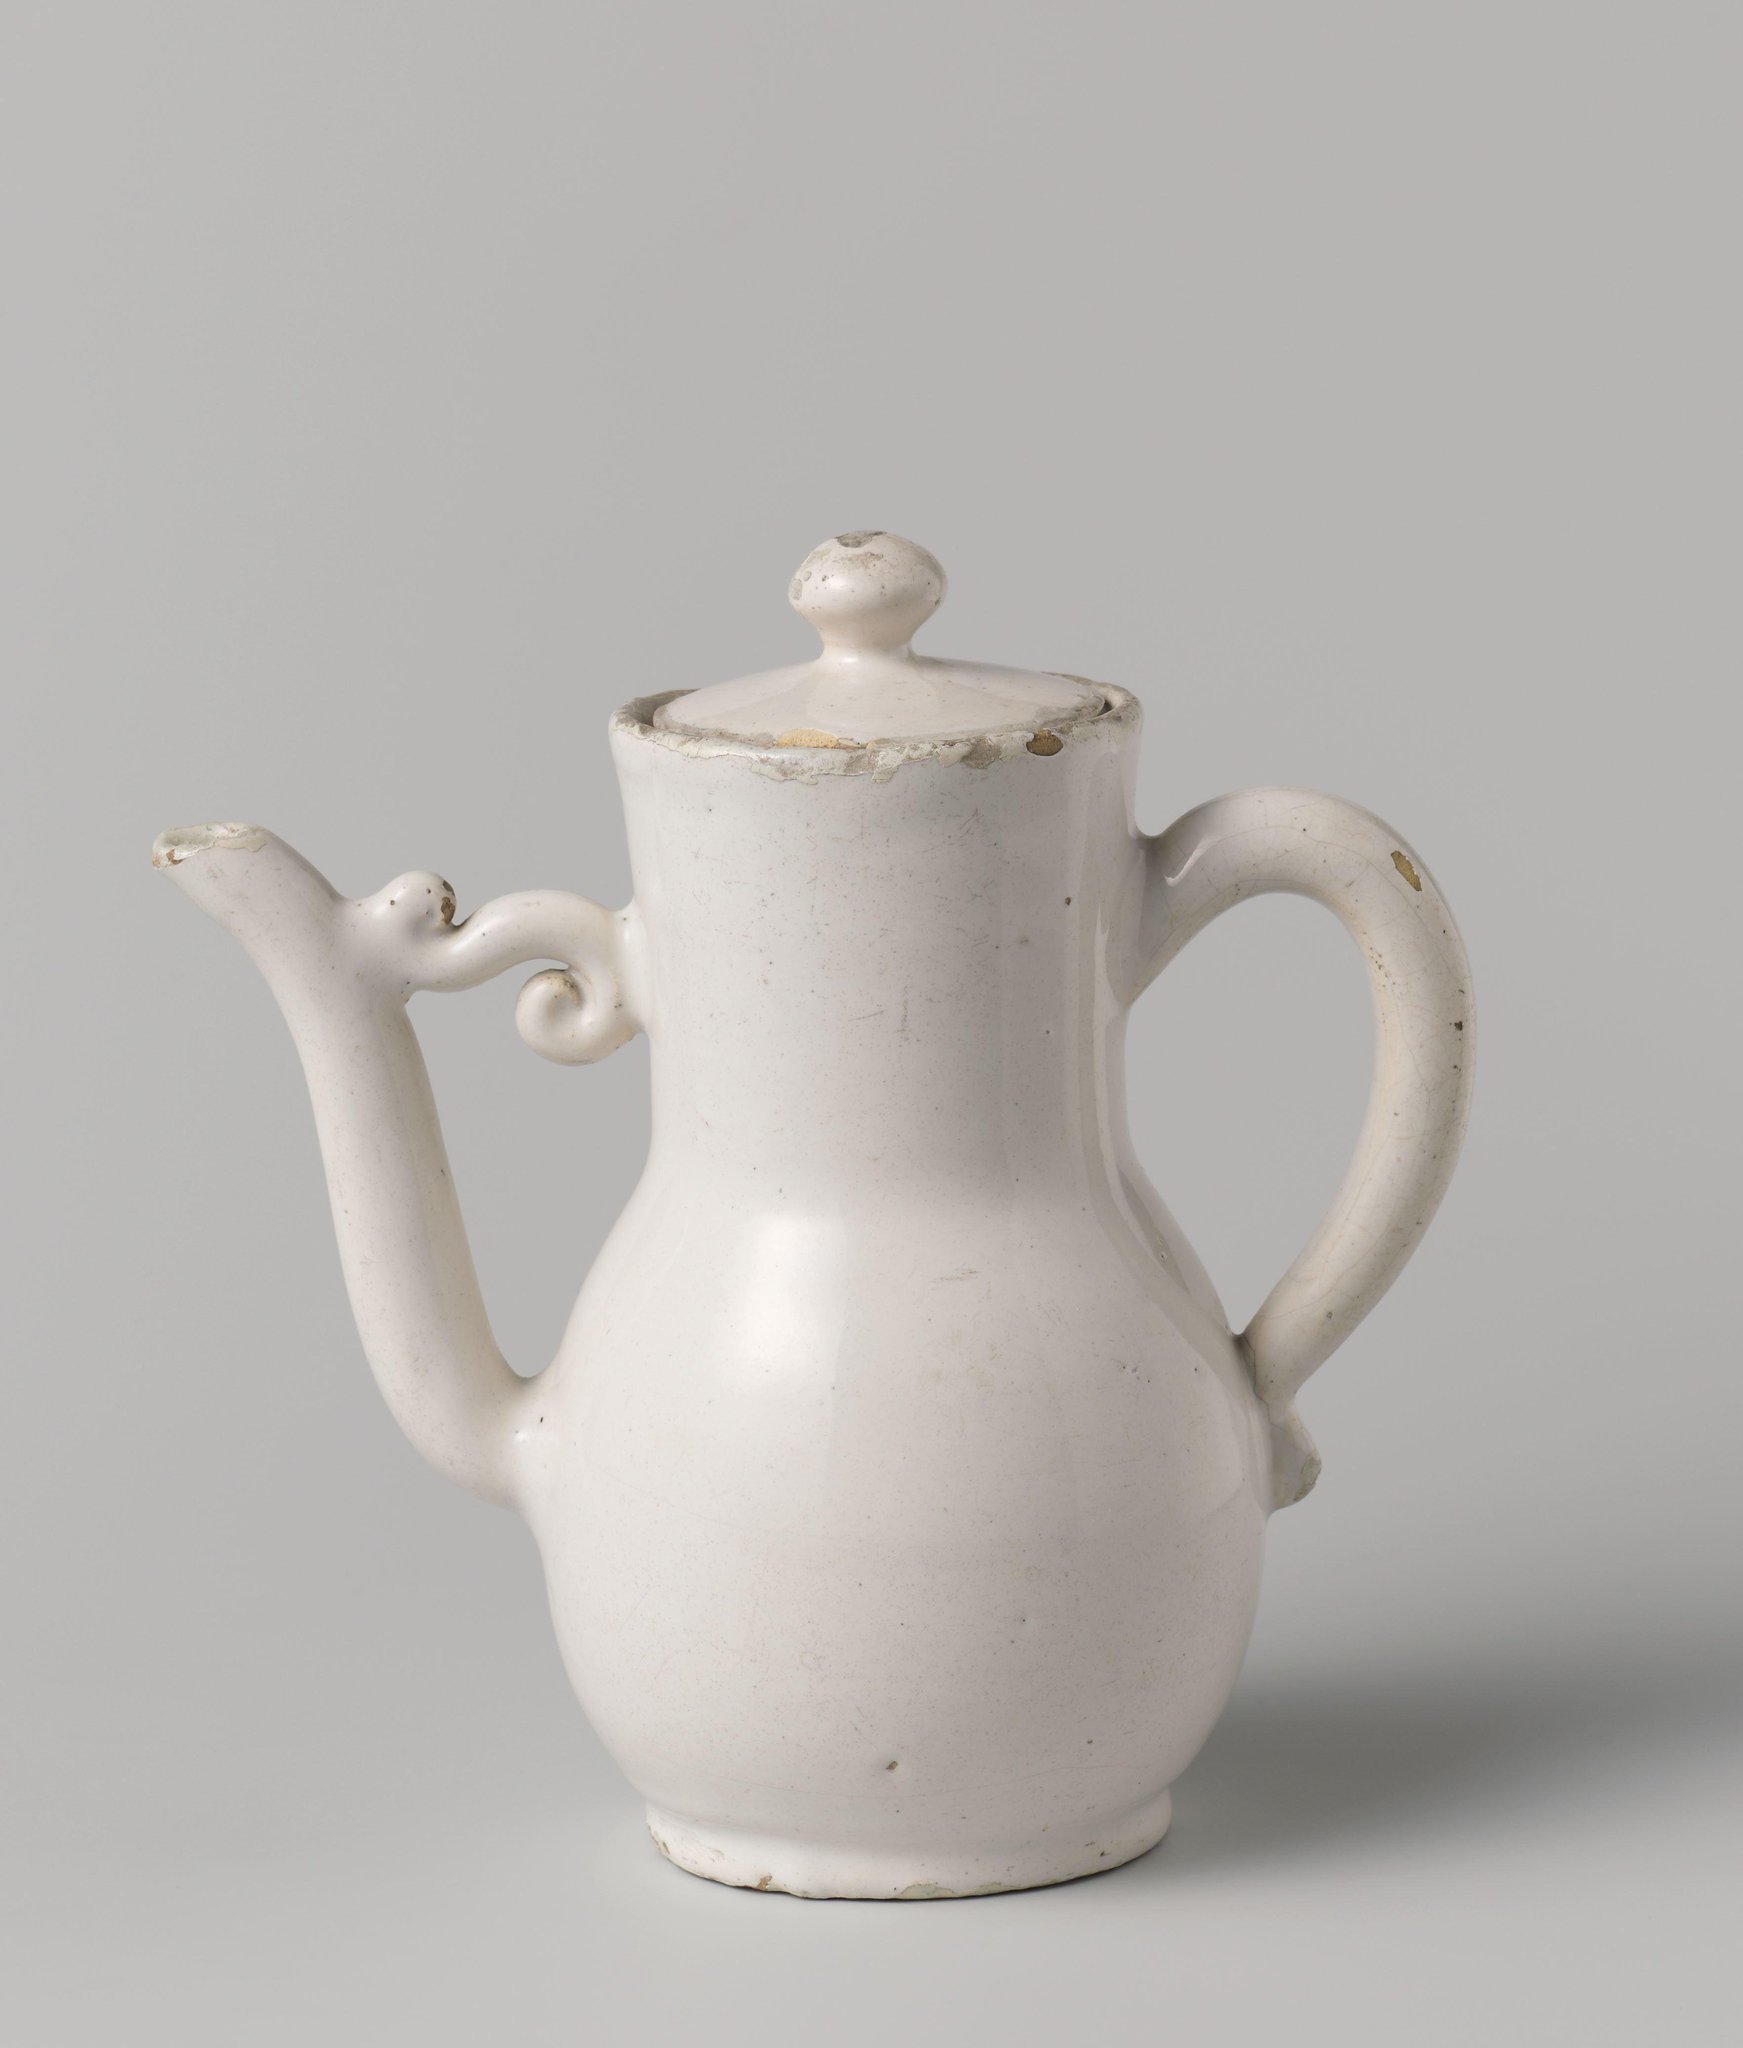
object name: lid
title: Deksel van kan van faience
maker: Anonymous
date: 1675-1725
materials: earthenware, glaze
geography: delft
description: Deksel met ronde knop van ongedecoreerde faience.